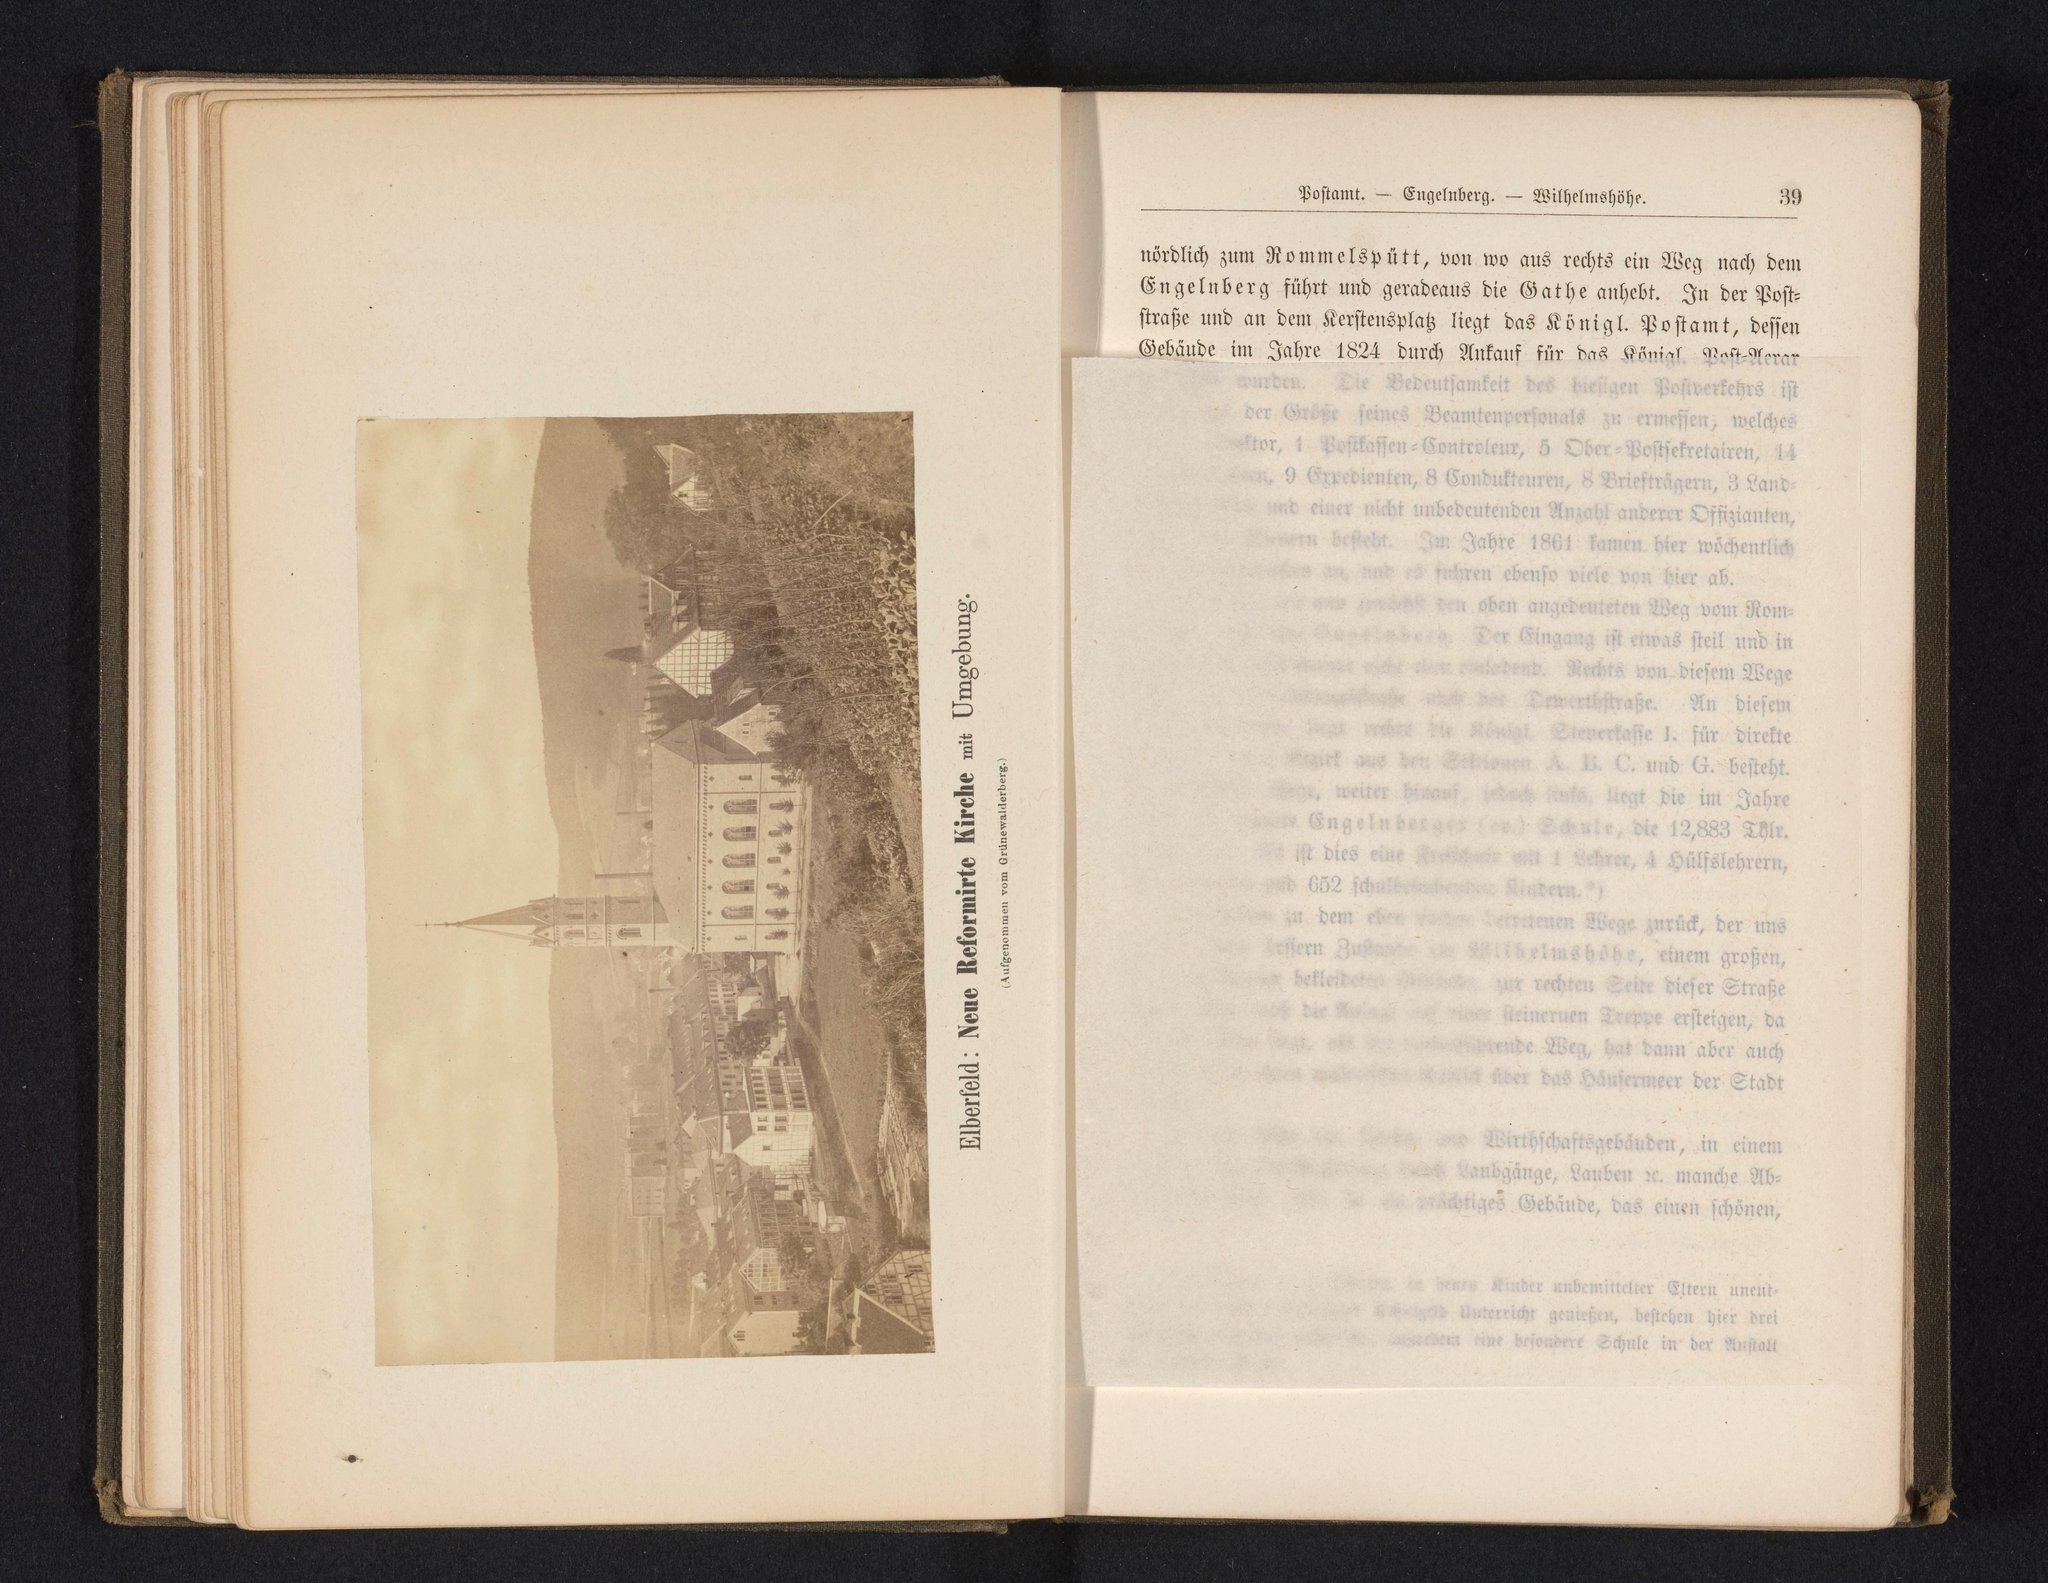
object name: page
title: Elberfeld : Neue Reformirt Kirche mit Umgebung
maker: Anonymous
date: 1853-1863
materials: photographic support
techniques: albumen print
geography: elberfeld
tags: church (exterior)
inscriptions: inscription: ‘(Aufgenommen vom Grünewalderberg.)’